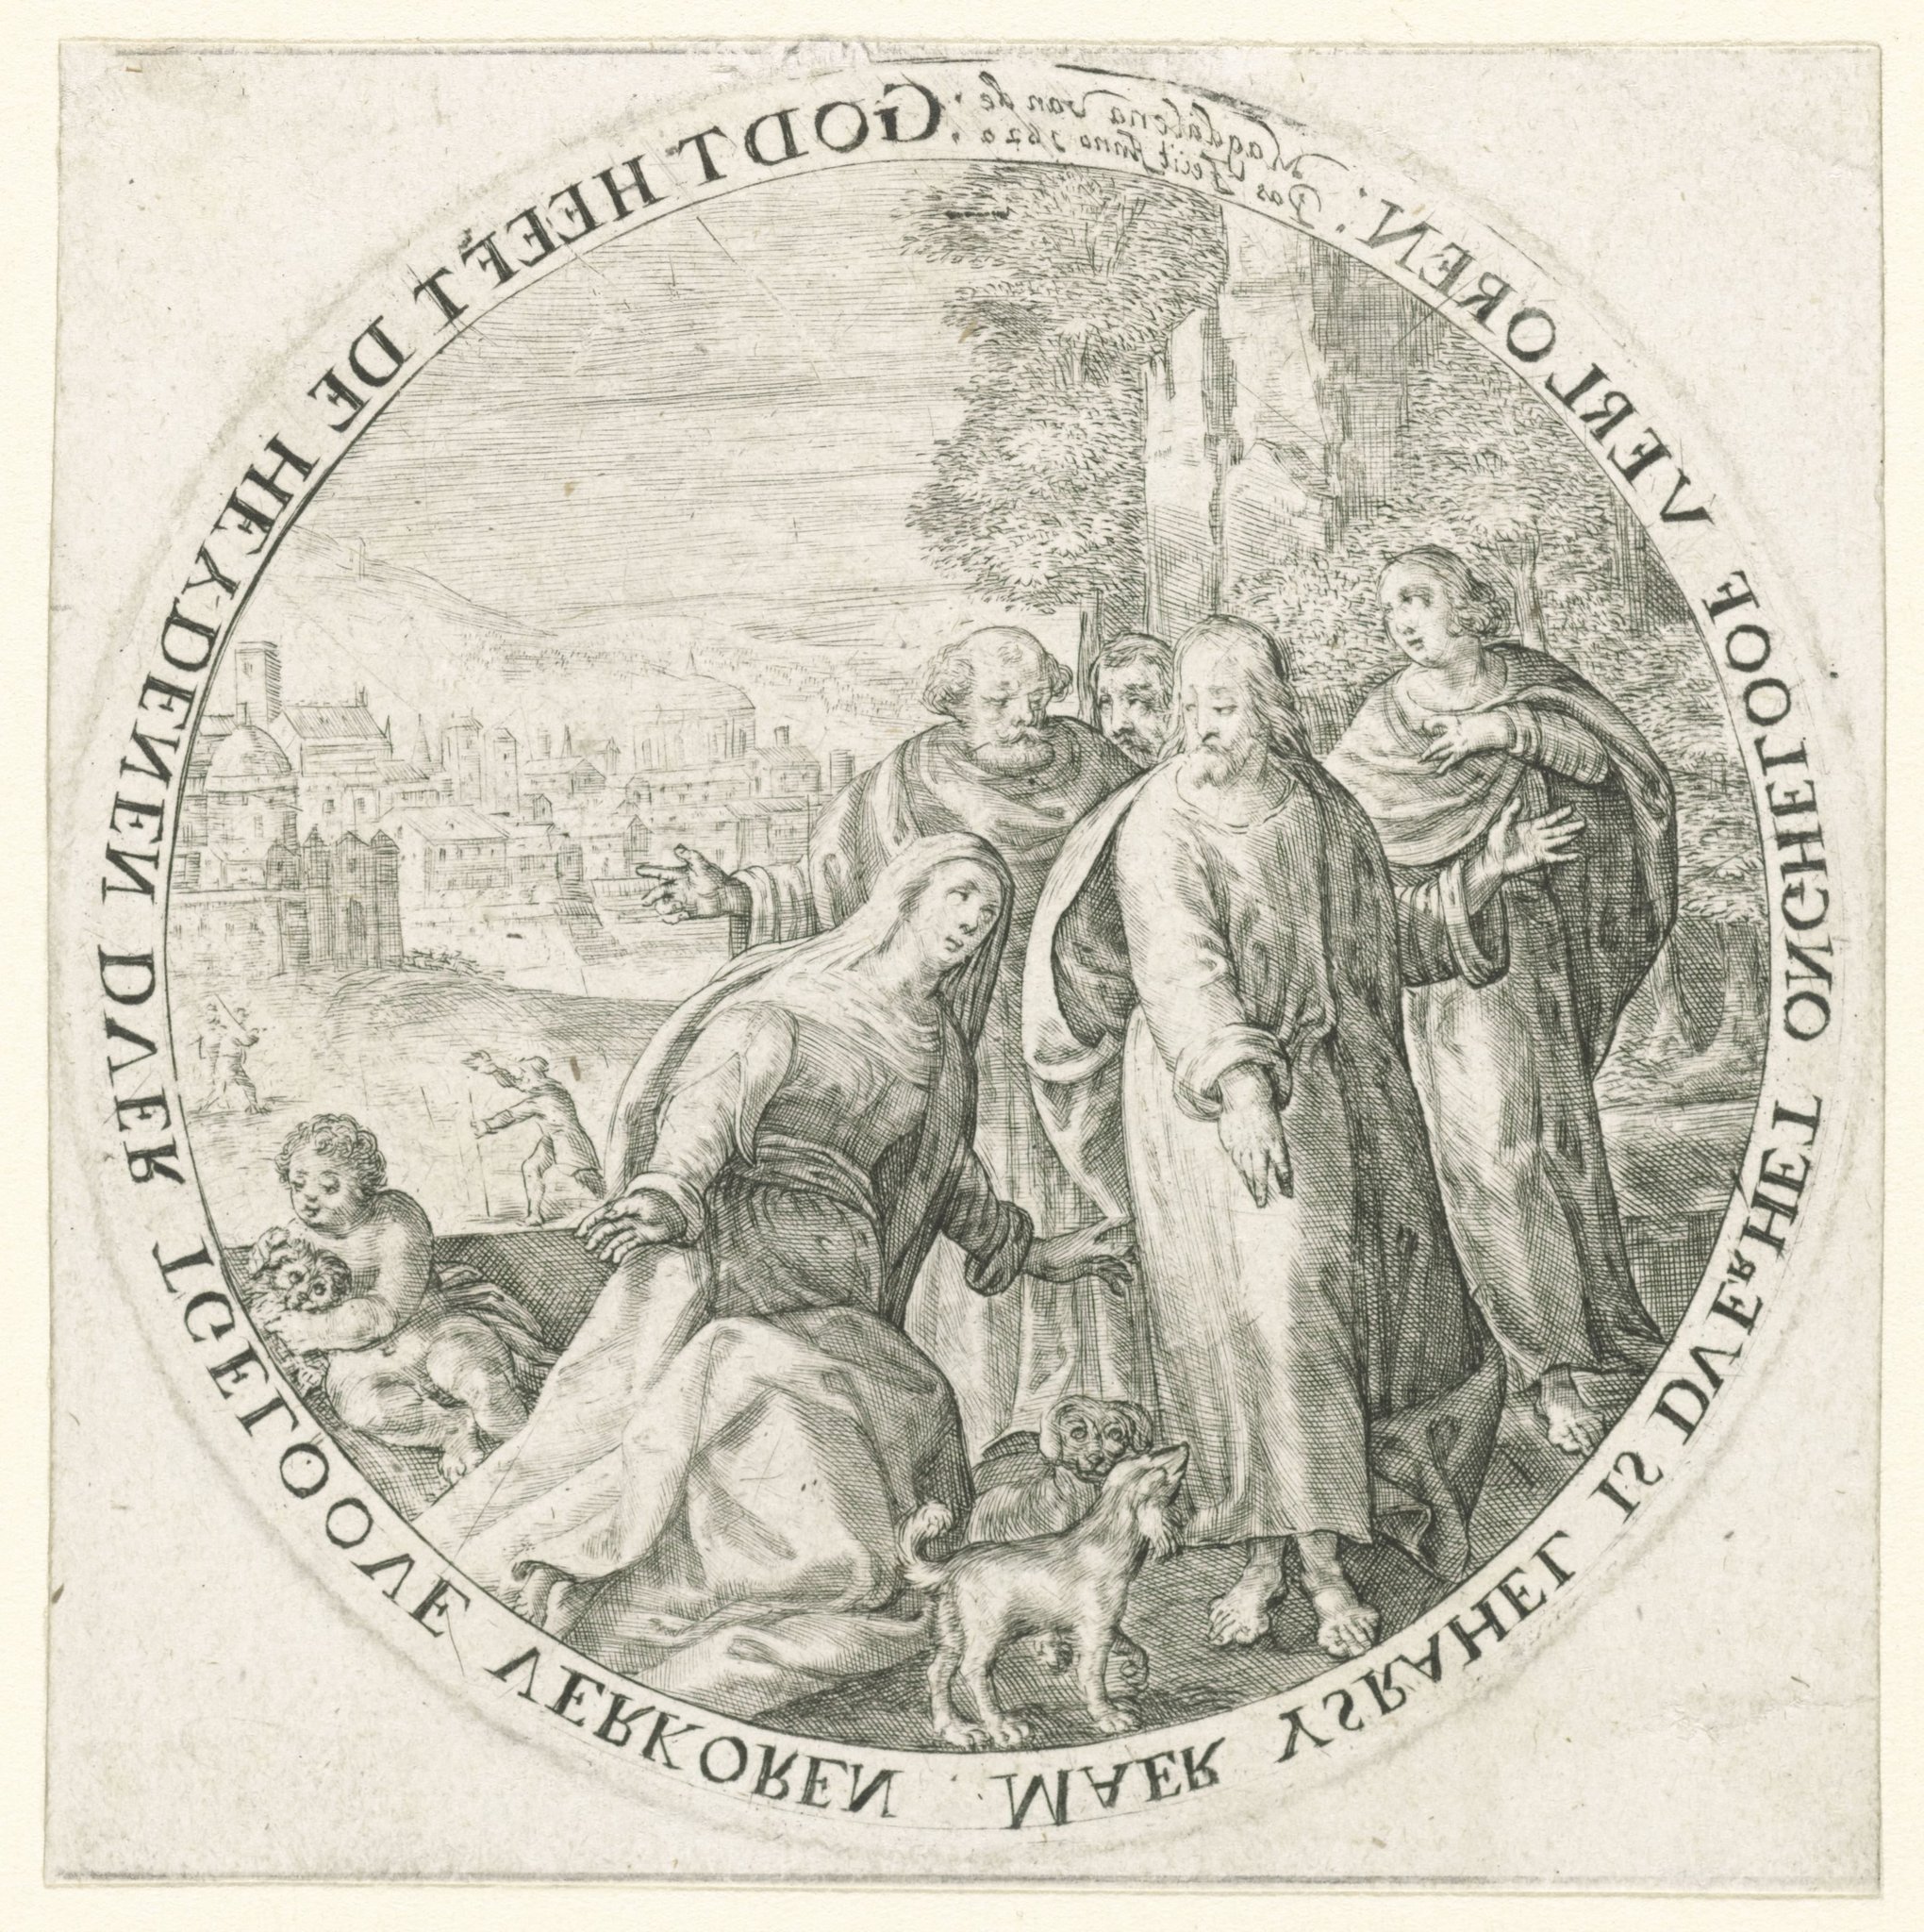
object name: print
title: Christus en de Kanaänitische vrouw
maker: magdalena van de passe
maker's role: print maker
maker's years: 1600-1638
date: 1620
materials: paper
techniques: engraving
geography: utrecht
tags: a canaanite woman kneels before christ, asking him to heal her daughter; the metaphor of the dogs and bread (matthew 15:21-28; mark 7:24-30)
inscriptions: collector's mark: Lugt 2760, collector's mark: Lugt 2228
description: Een Kanaänitische vrouw knielt voor Christus en smeekt hem haar dochter te genezen. Voorheen ten onrechte geïnterpreteerd als de genezing van de bloedvloeiende vrouw. De voorstelling is gevat in een ronde omlijsting met een randschrift, in spiegelbeeld, in het Latijn.